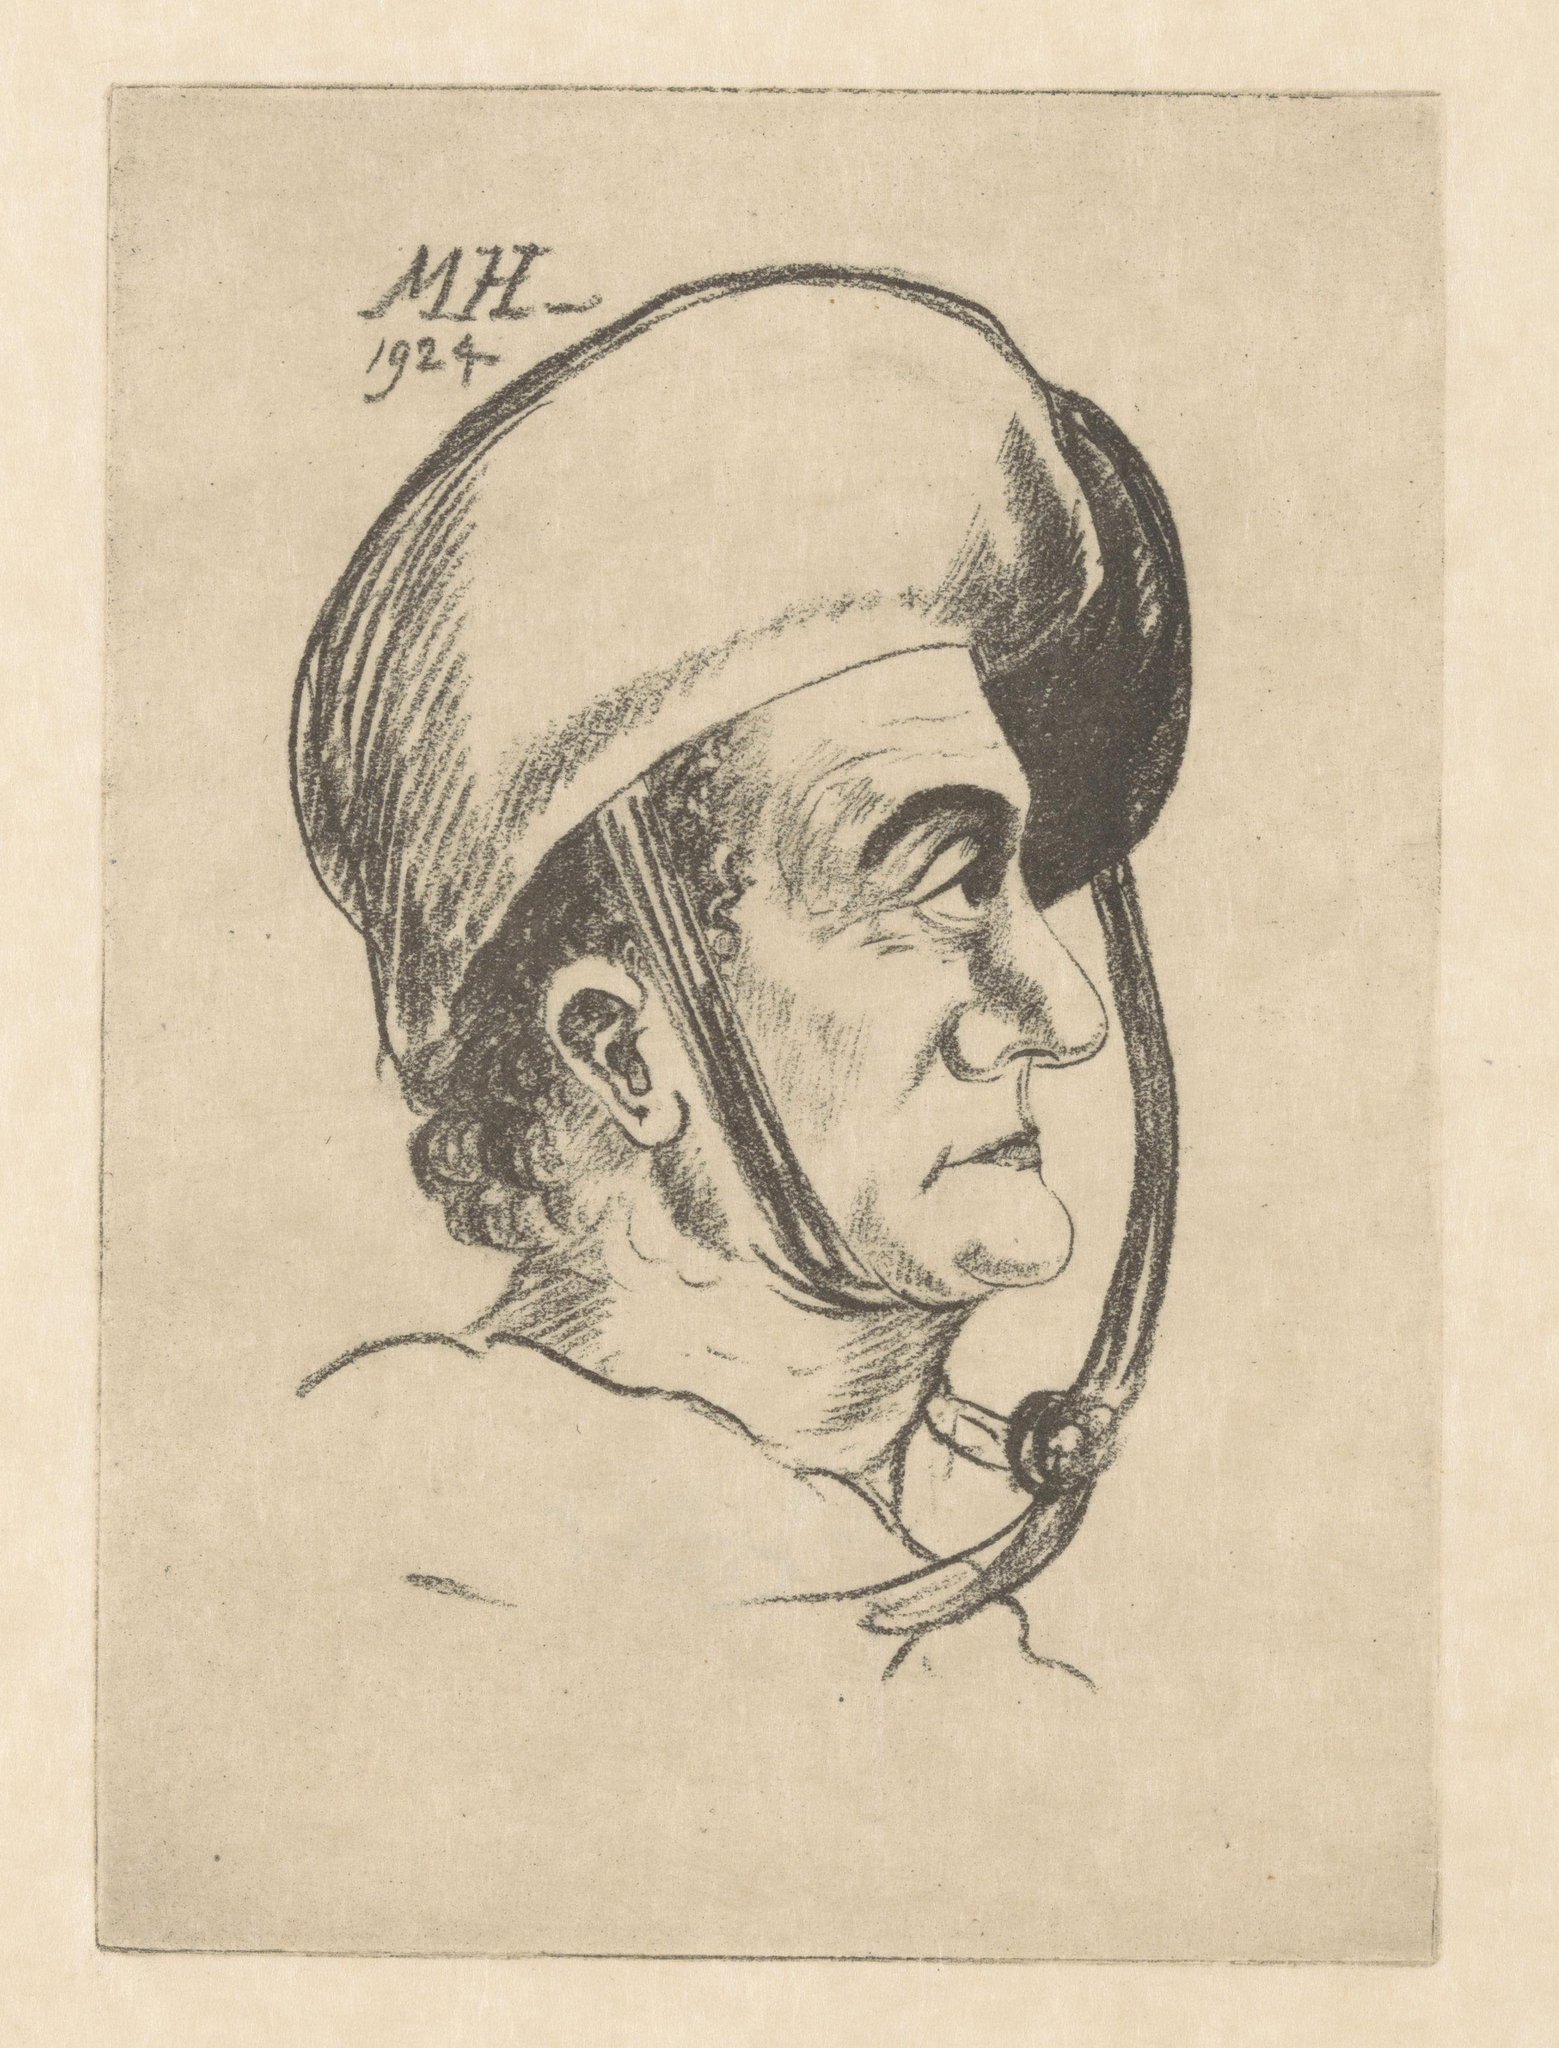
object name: print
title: Soldaat en profil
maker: marius holleman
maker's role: draughtsman, print maker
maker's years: 1878-1926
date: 1924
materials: paper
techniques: etching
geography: groningen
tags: uniform cap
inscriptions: collector's mark: Lugt 2228